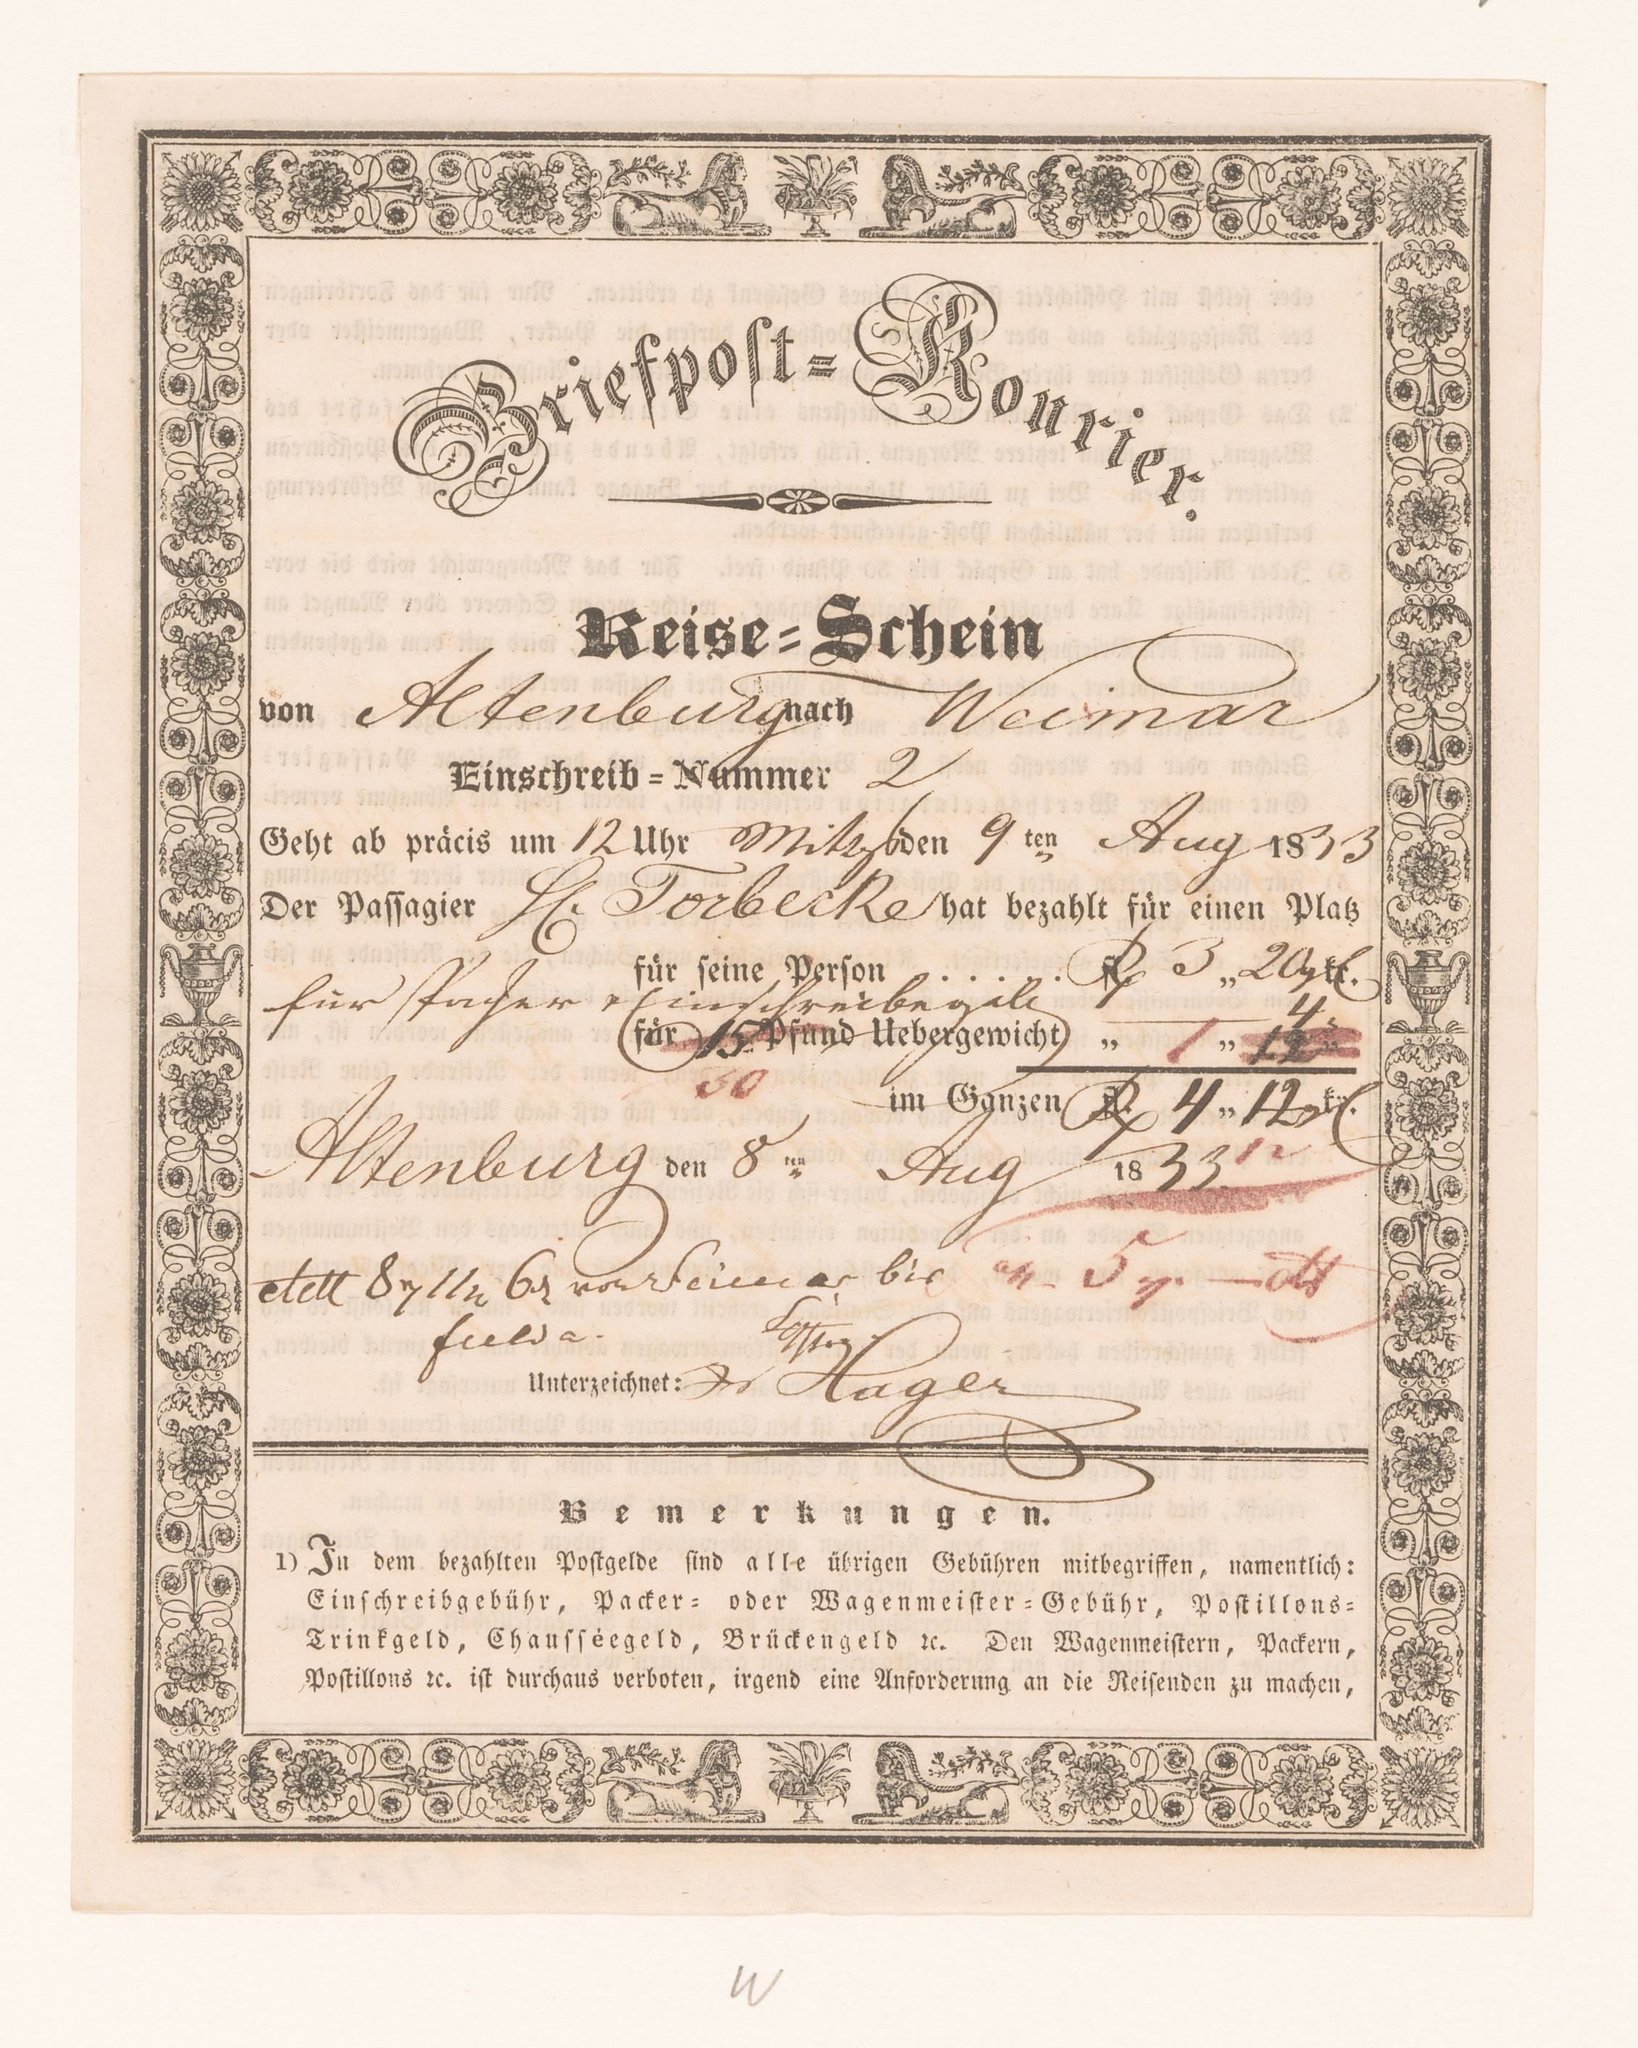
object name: travel document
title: Reisdocument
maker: Anonymous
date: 1833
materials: paper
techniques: printing, writing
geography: germany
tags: the hague, johan rudolf thorbecke, germany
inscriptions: date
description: Reise-Schein Briefpost Kourier Altenburg-Weimar. Gedateerd: 8 aug. 1833.